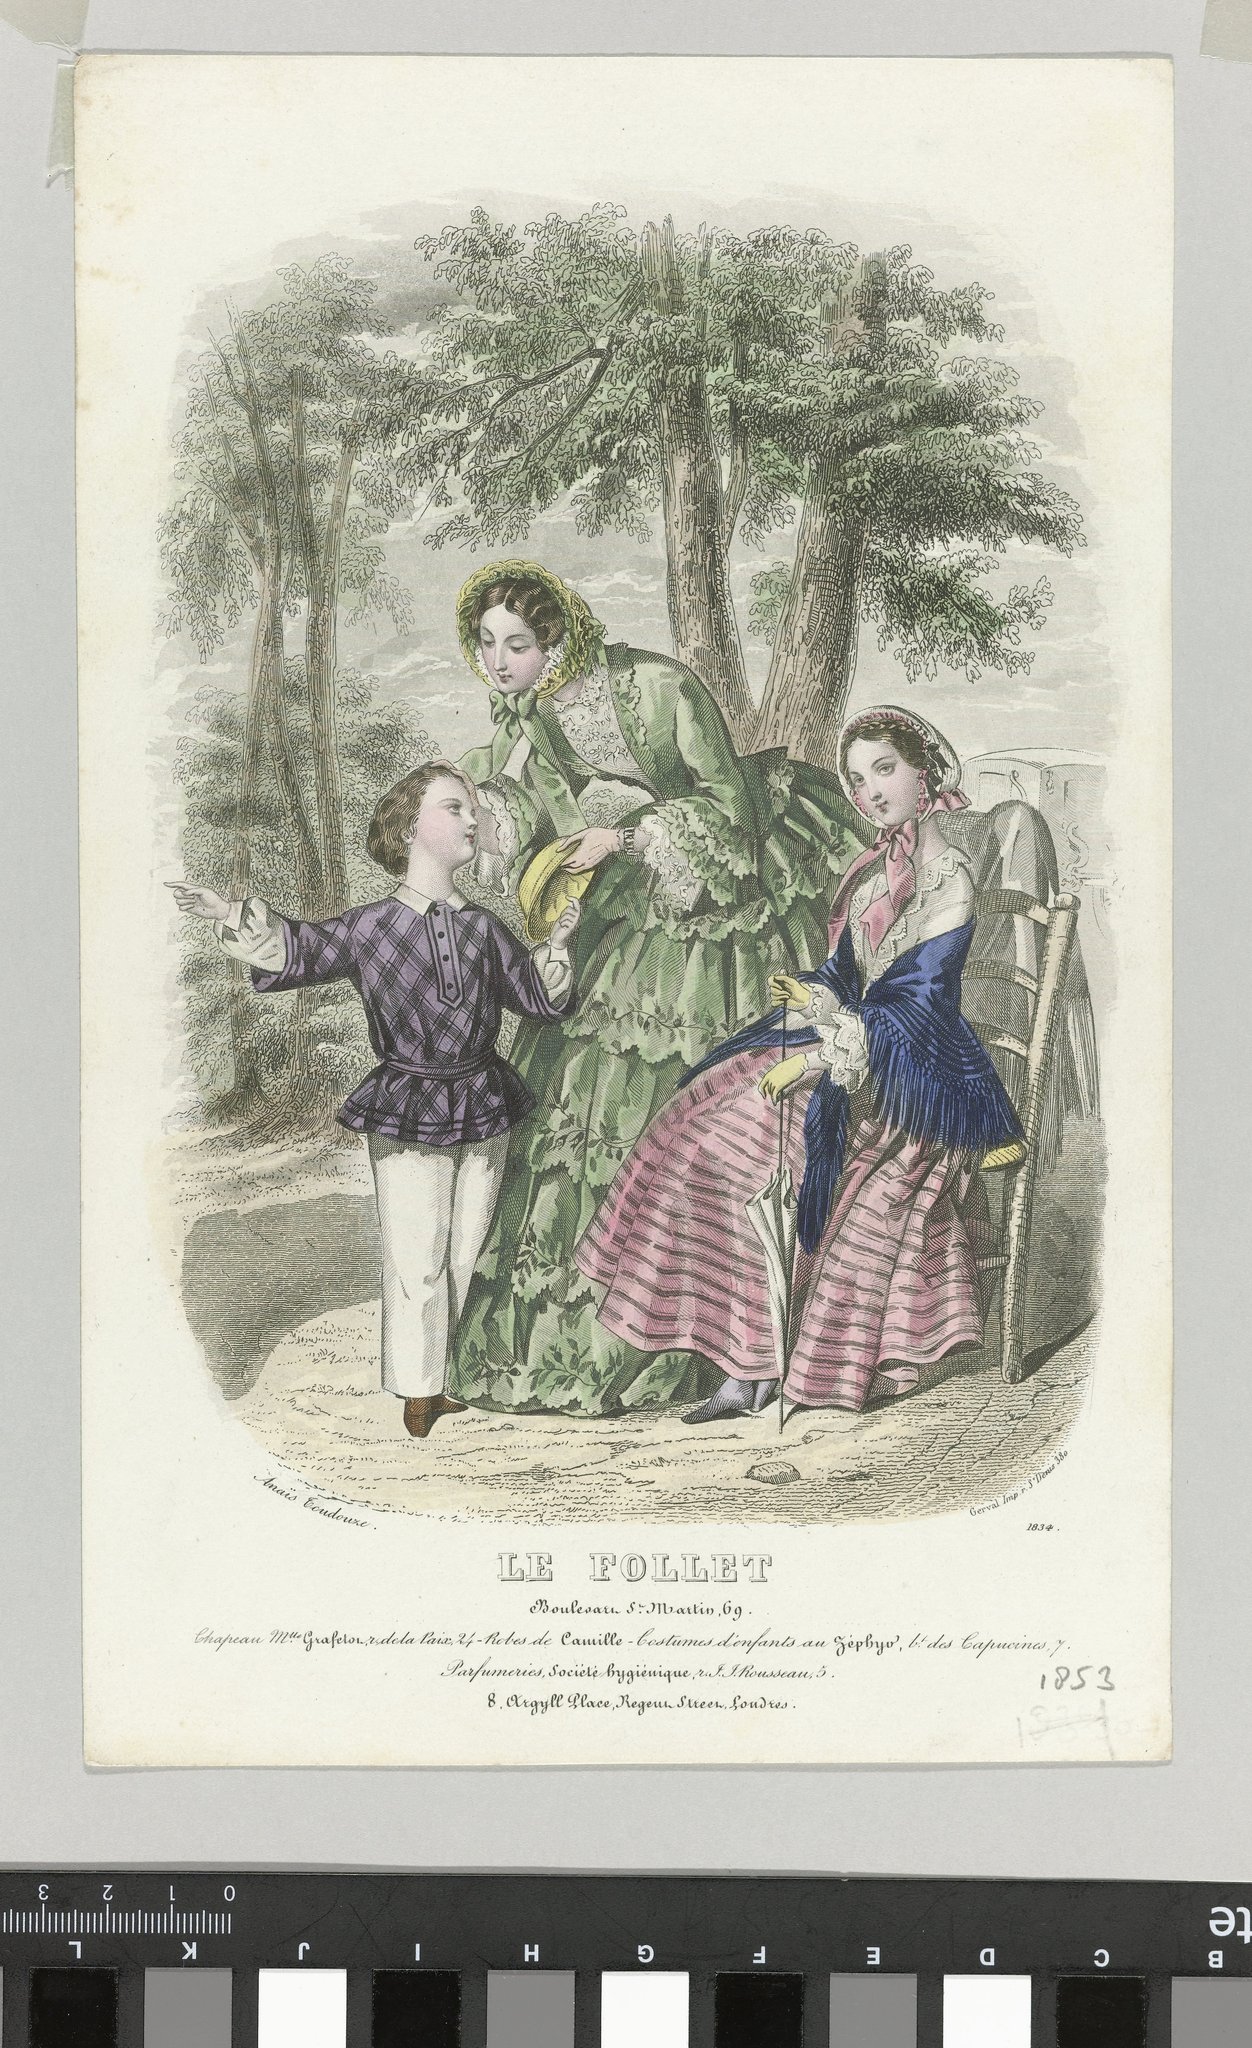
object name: fashion print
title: Le Follet, 1853, No. 1834 : Chapeau M.lle Grafetor (...)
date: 1853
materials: paper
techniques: hand coloring, engraving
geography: paris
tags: clothing for the upper part of the body (shawl) (+ women's clothes), head-gear: hat (+ girls' clothes), trousers, breeches (+ boys' clothes), clothing for the upper part of the body (+ boys' clothes), parasol, sunshade (+ girls' clothes), clothing for the upper part of the body (shawl) (+ girls' clothes), fashion plates, head-gear: hat (+ women's clothes), gloves, mittens, etc. (+ women's clothes), bracelet, wristlet (+ women's clothes), dress, gown (+ girls' clothes)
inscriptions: address: ‘Boulevart S.t Martin, 69 / 8, Argyll Place, Regent Street, Londres.’, caption: ‘Chapeaux M.lle Grafetor, r. de la Paix, 24 - Robes de Camille - Costumes d'enfants au Zéphyr, b.t des Capucines, 7. Parfumeries, Société hygiénique, r. J.J. Rousseau, 5.’, title: ‘Le Follet’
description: Een vrouw met een jongen en meisje in een park. Onder de voorstelling enkele regels reclametekst voor verschillende producten. Prent uit het modetijdschrift Le Follet Courrier des Salons (novembre 1829-octobre 1882).